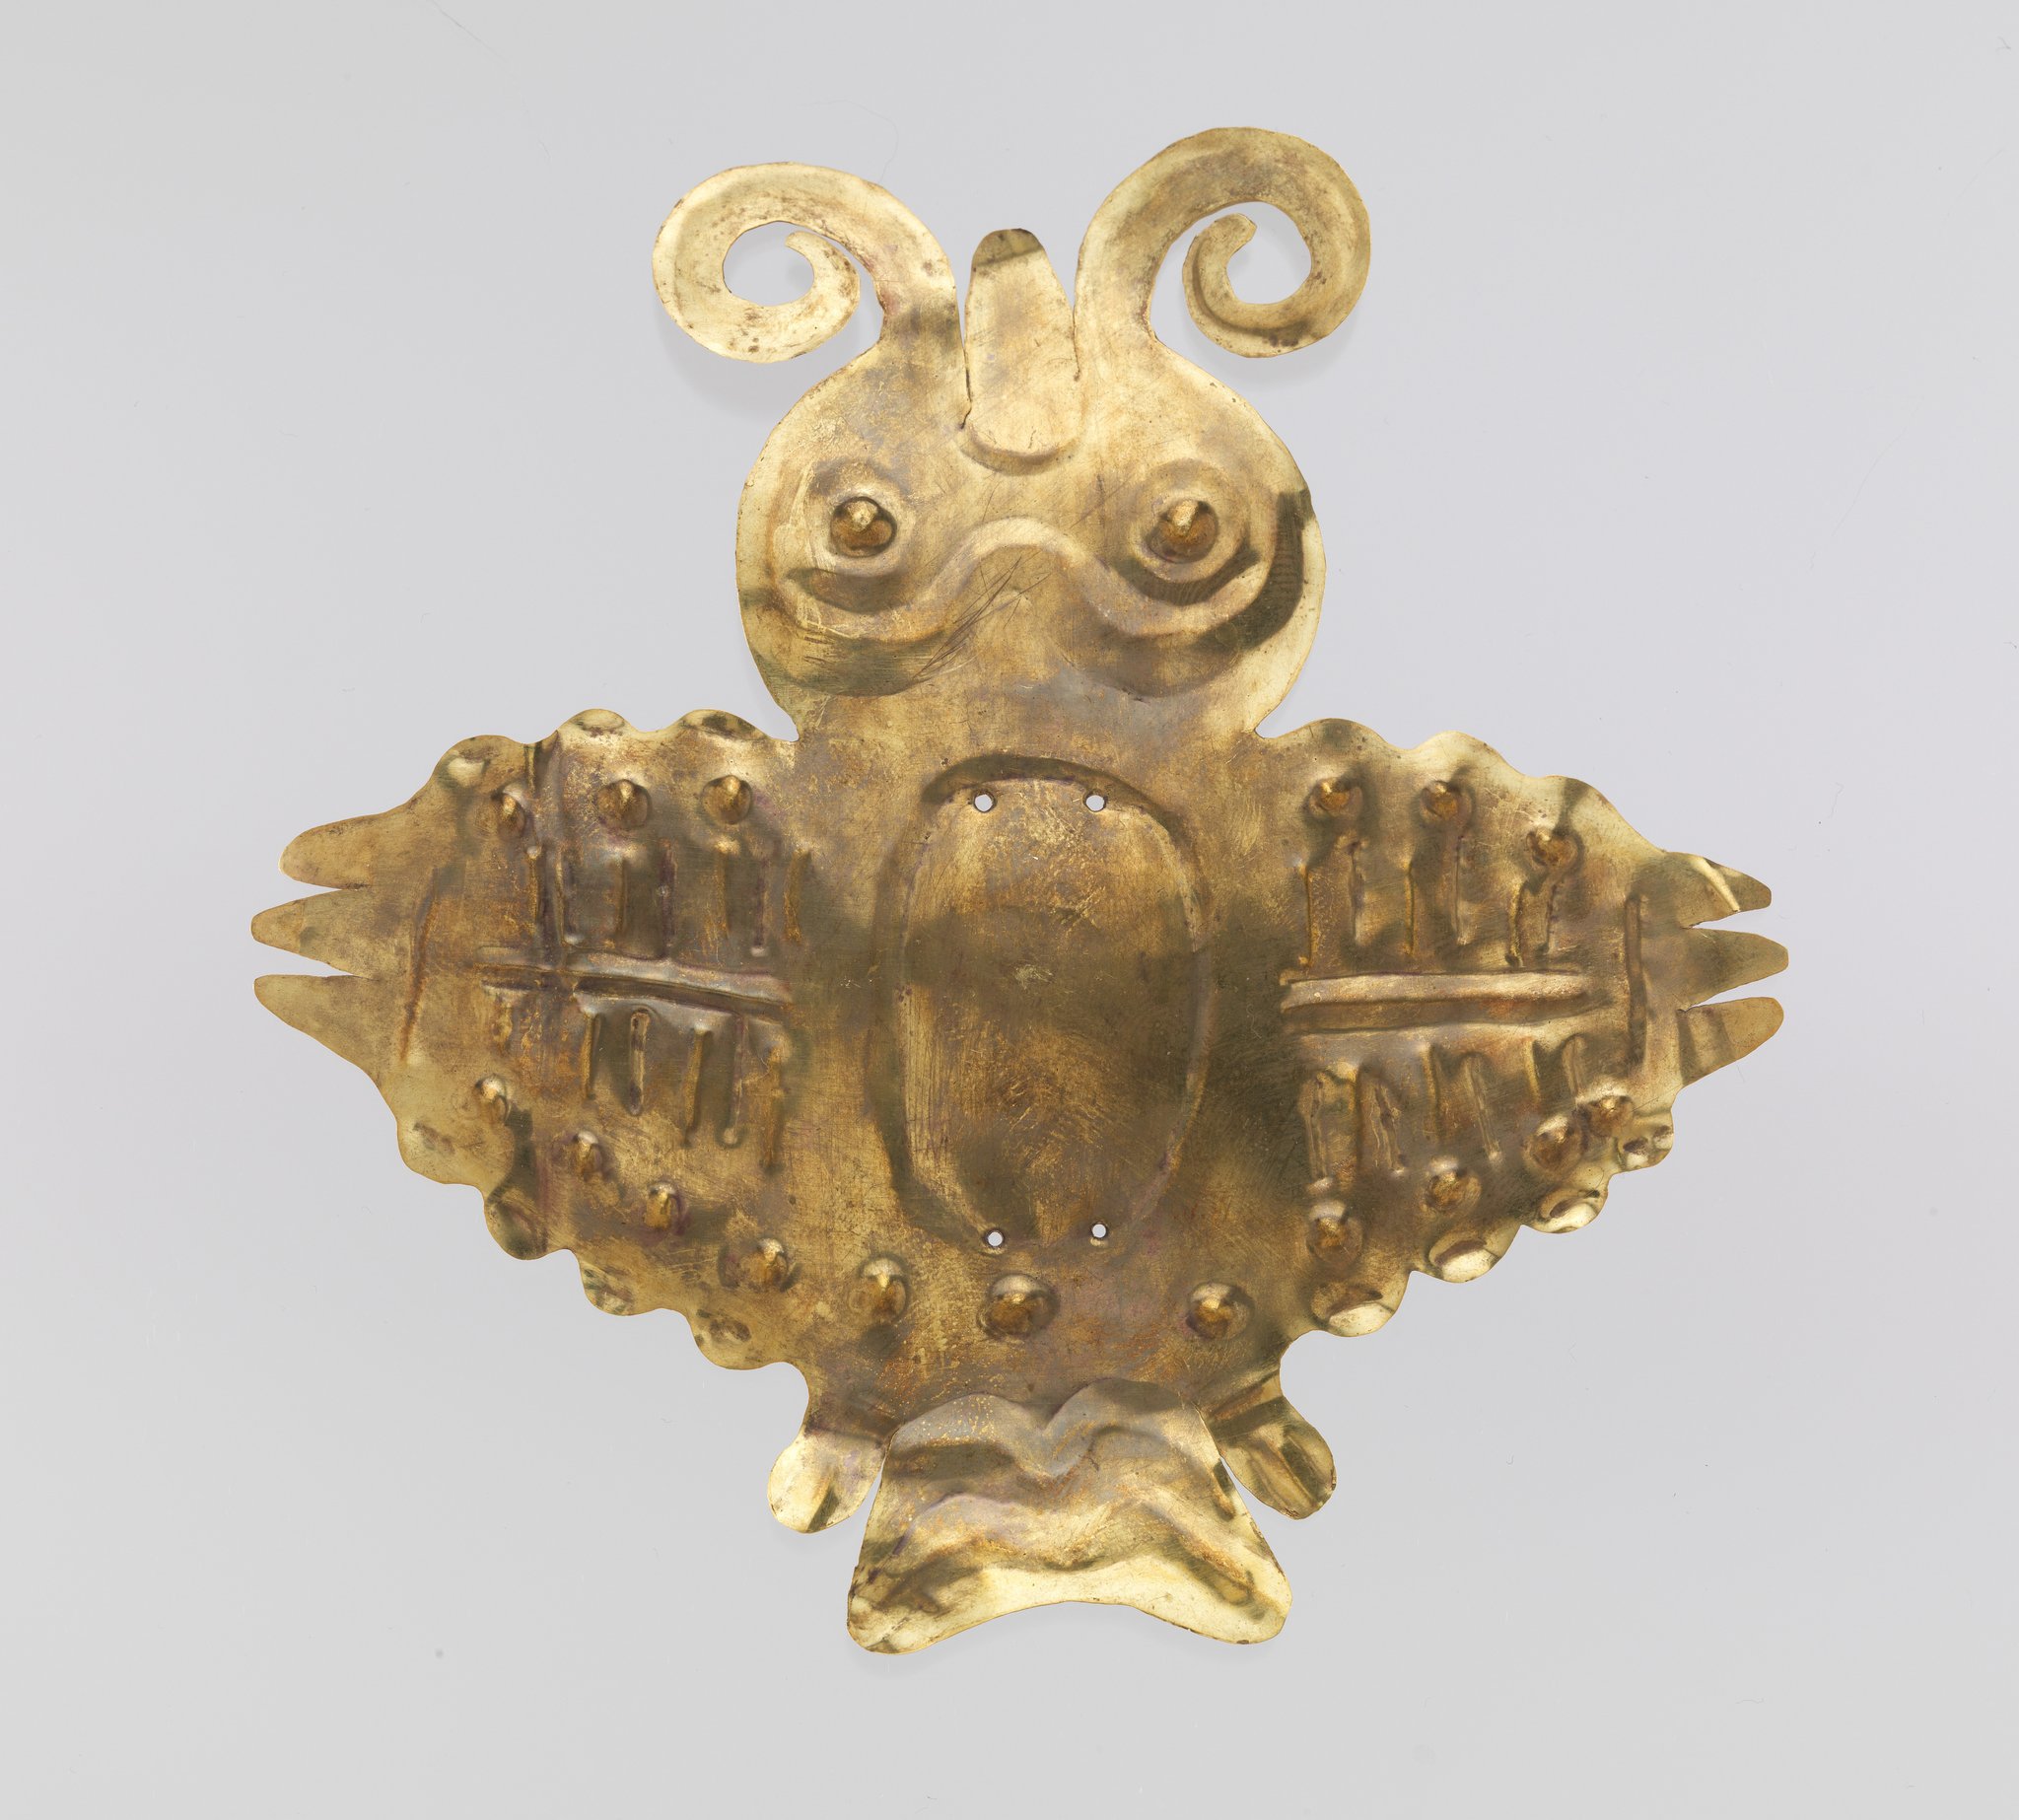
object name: ornament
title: Bird-shaped ornament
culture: nasca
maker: nasca artist(s)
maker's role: artist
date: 1-700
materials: gold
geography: peru